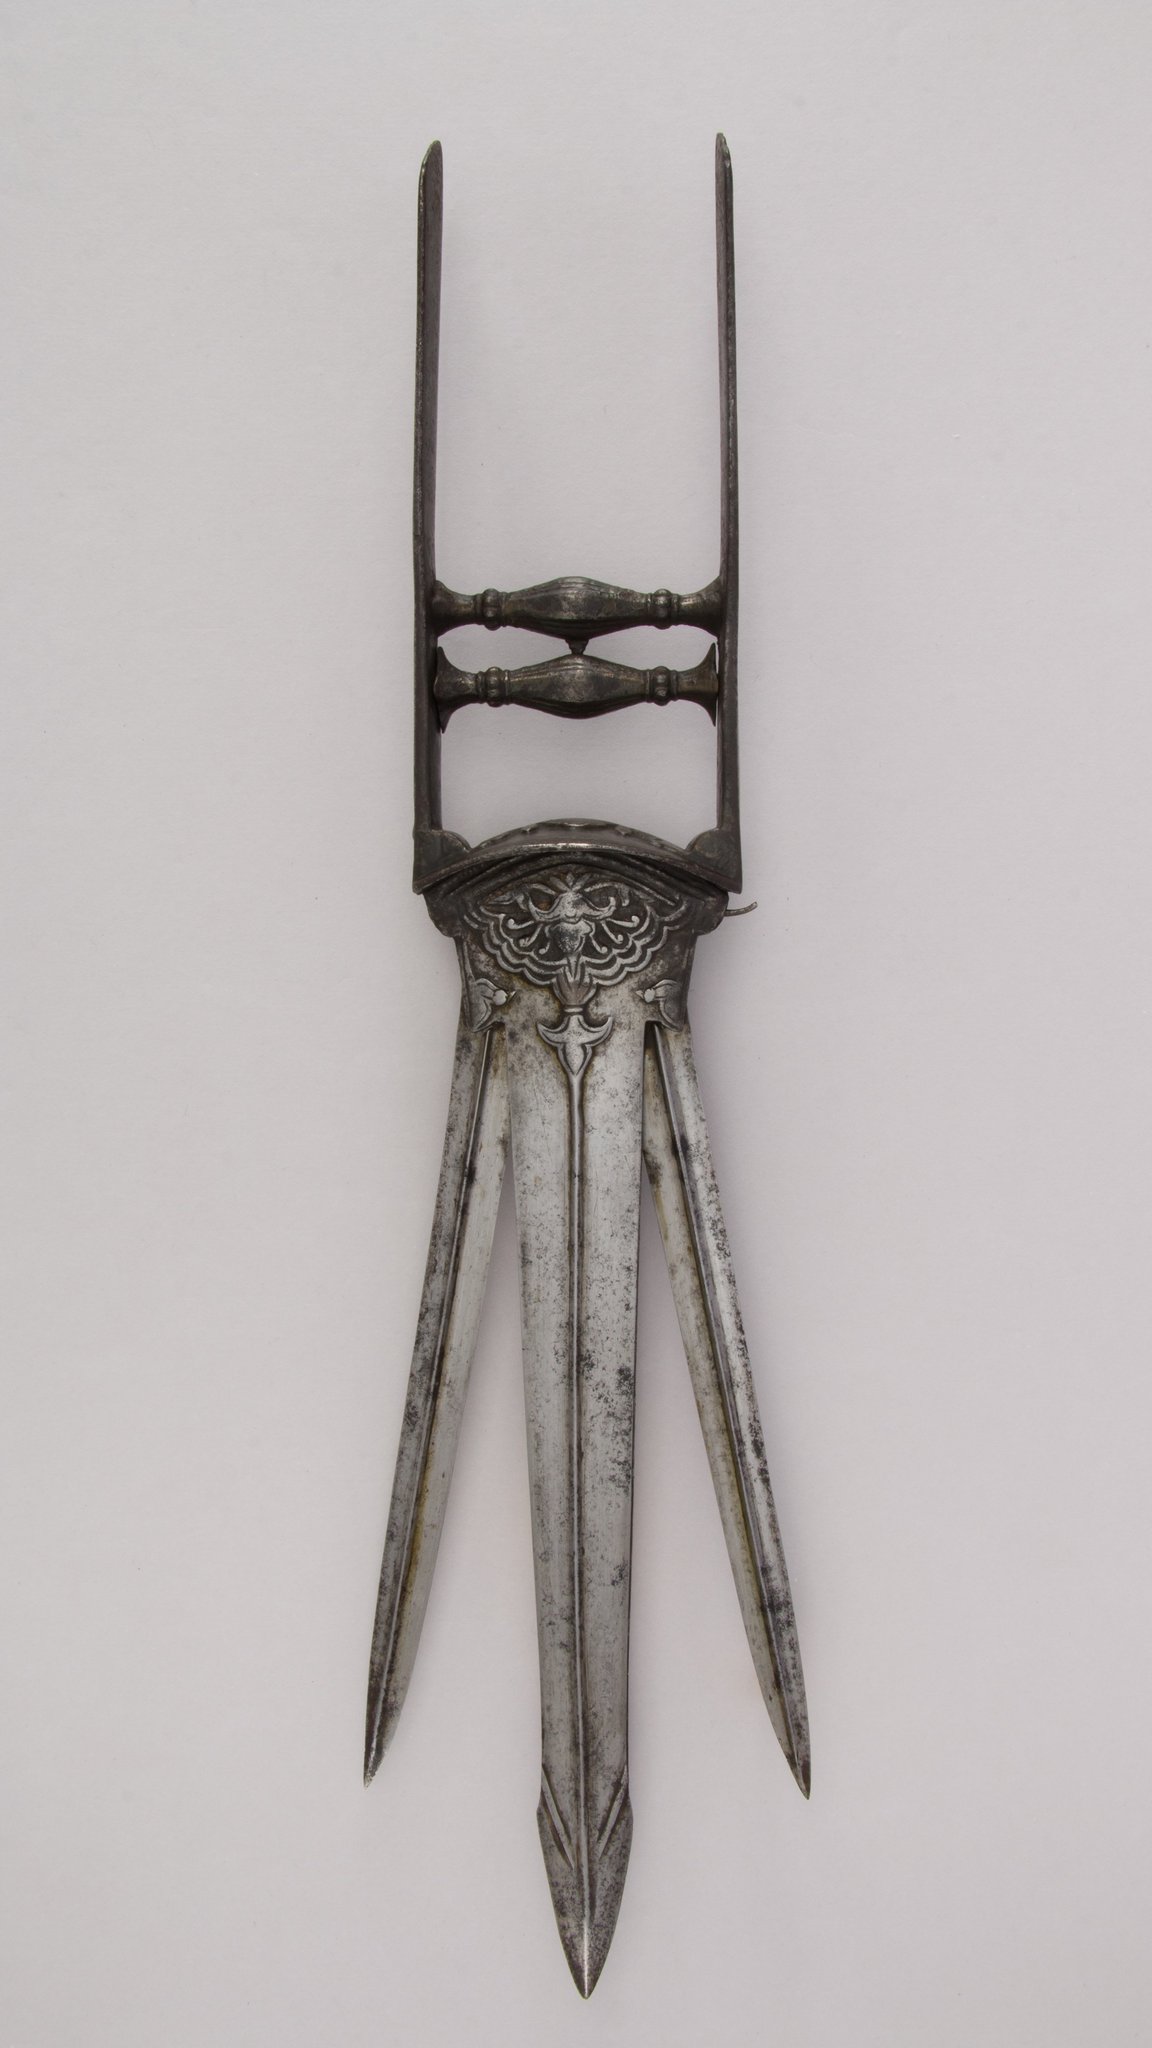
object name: dagger katar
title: Dagger (Katar)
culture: indian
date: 1701-1900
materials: silver, steel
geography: north india